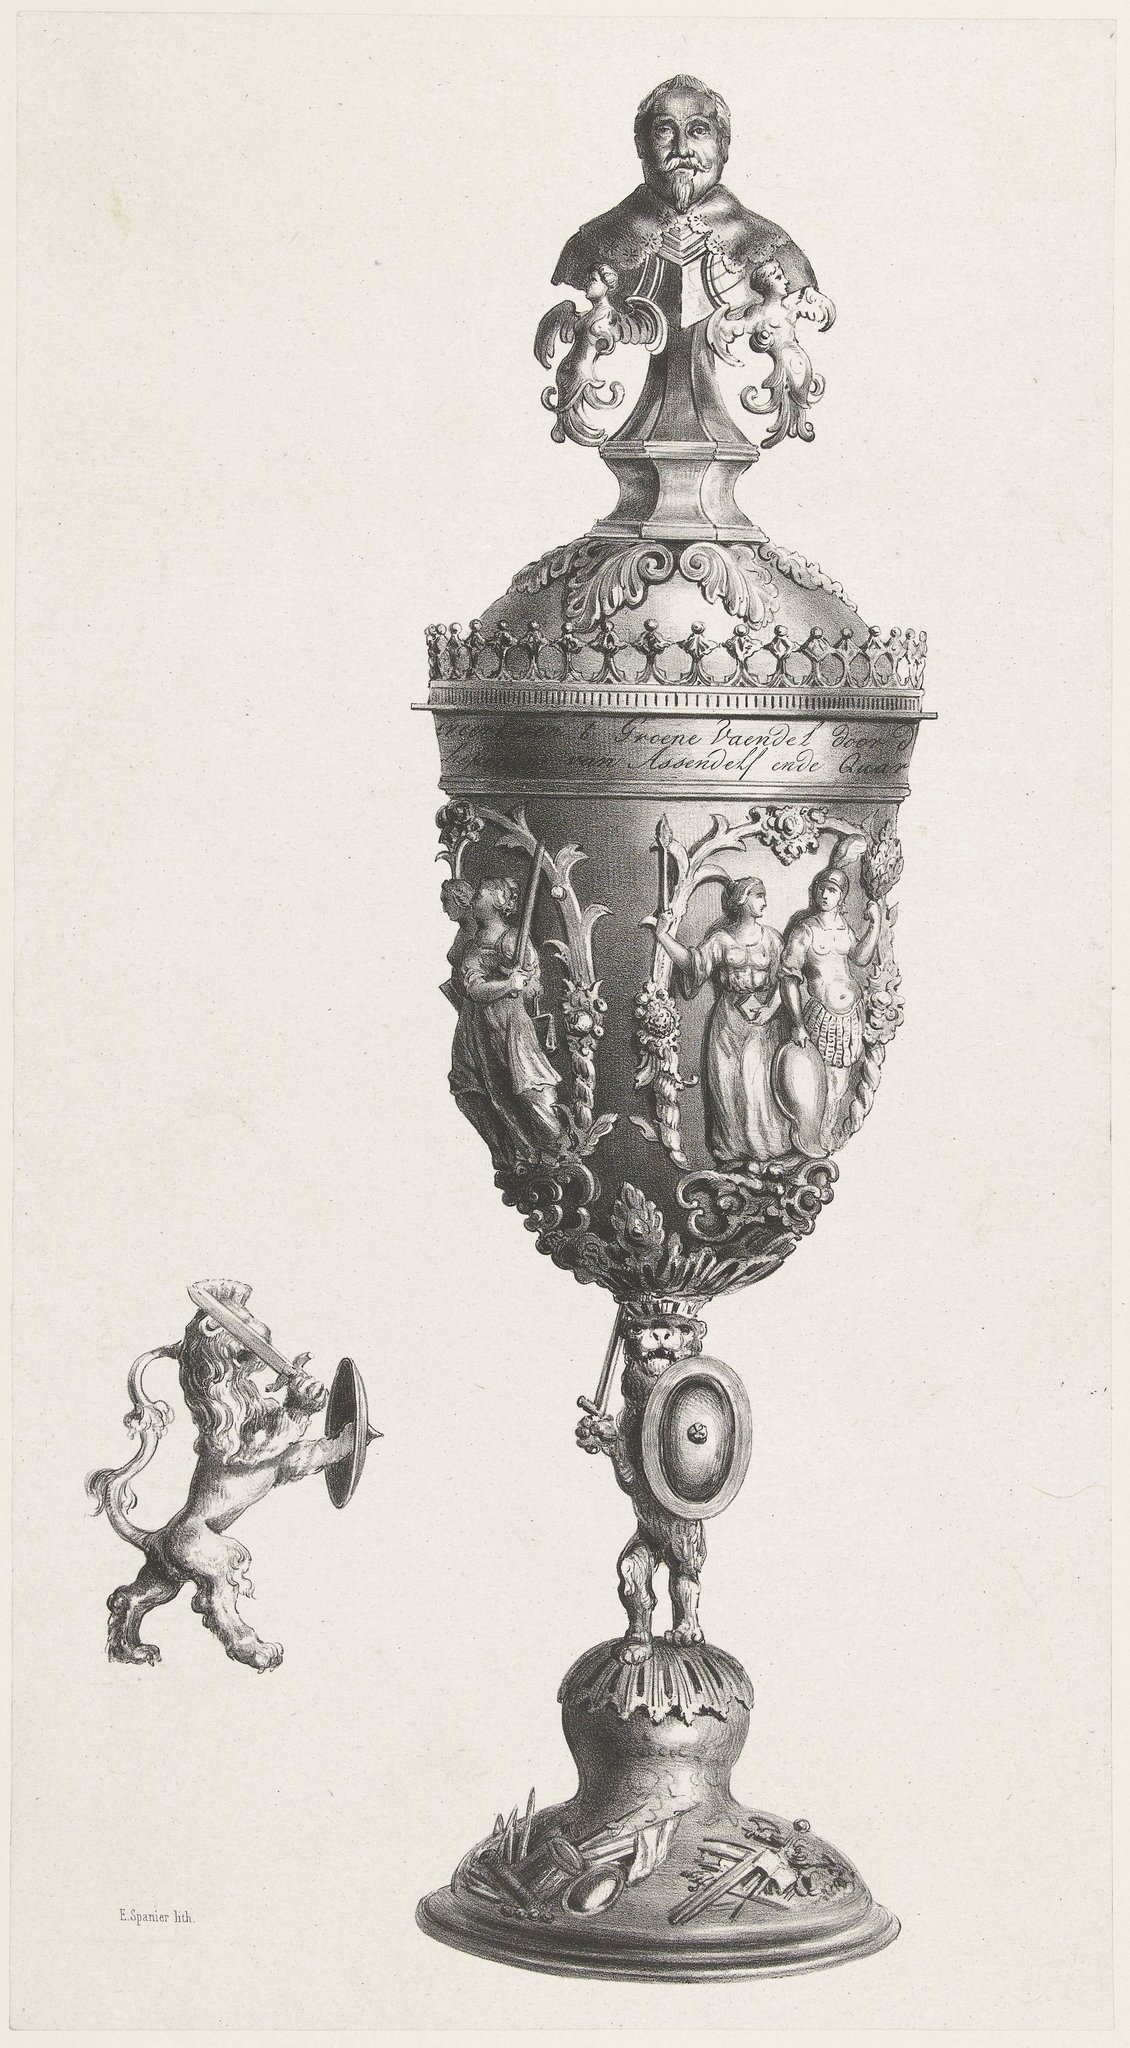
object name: historical object representation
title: Bokaal vereerd aan het Groene Vaendel, 1714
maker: elias spanier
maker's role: print maker, printer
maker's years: 1821-1863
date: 1831-1863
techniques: printmaking, lithograph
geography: netherlands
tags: cup, assendelft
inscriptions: collector's mark: Lugt 2228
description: Bokaal versierd met allegorische figuren, vereerd aan de compagnie van het Groene Vaendel door de burgemeester en schepenen van Assendelft, 20 januari 1714.